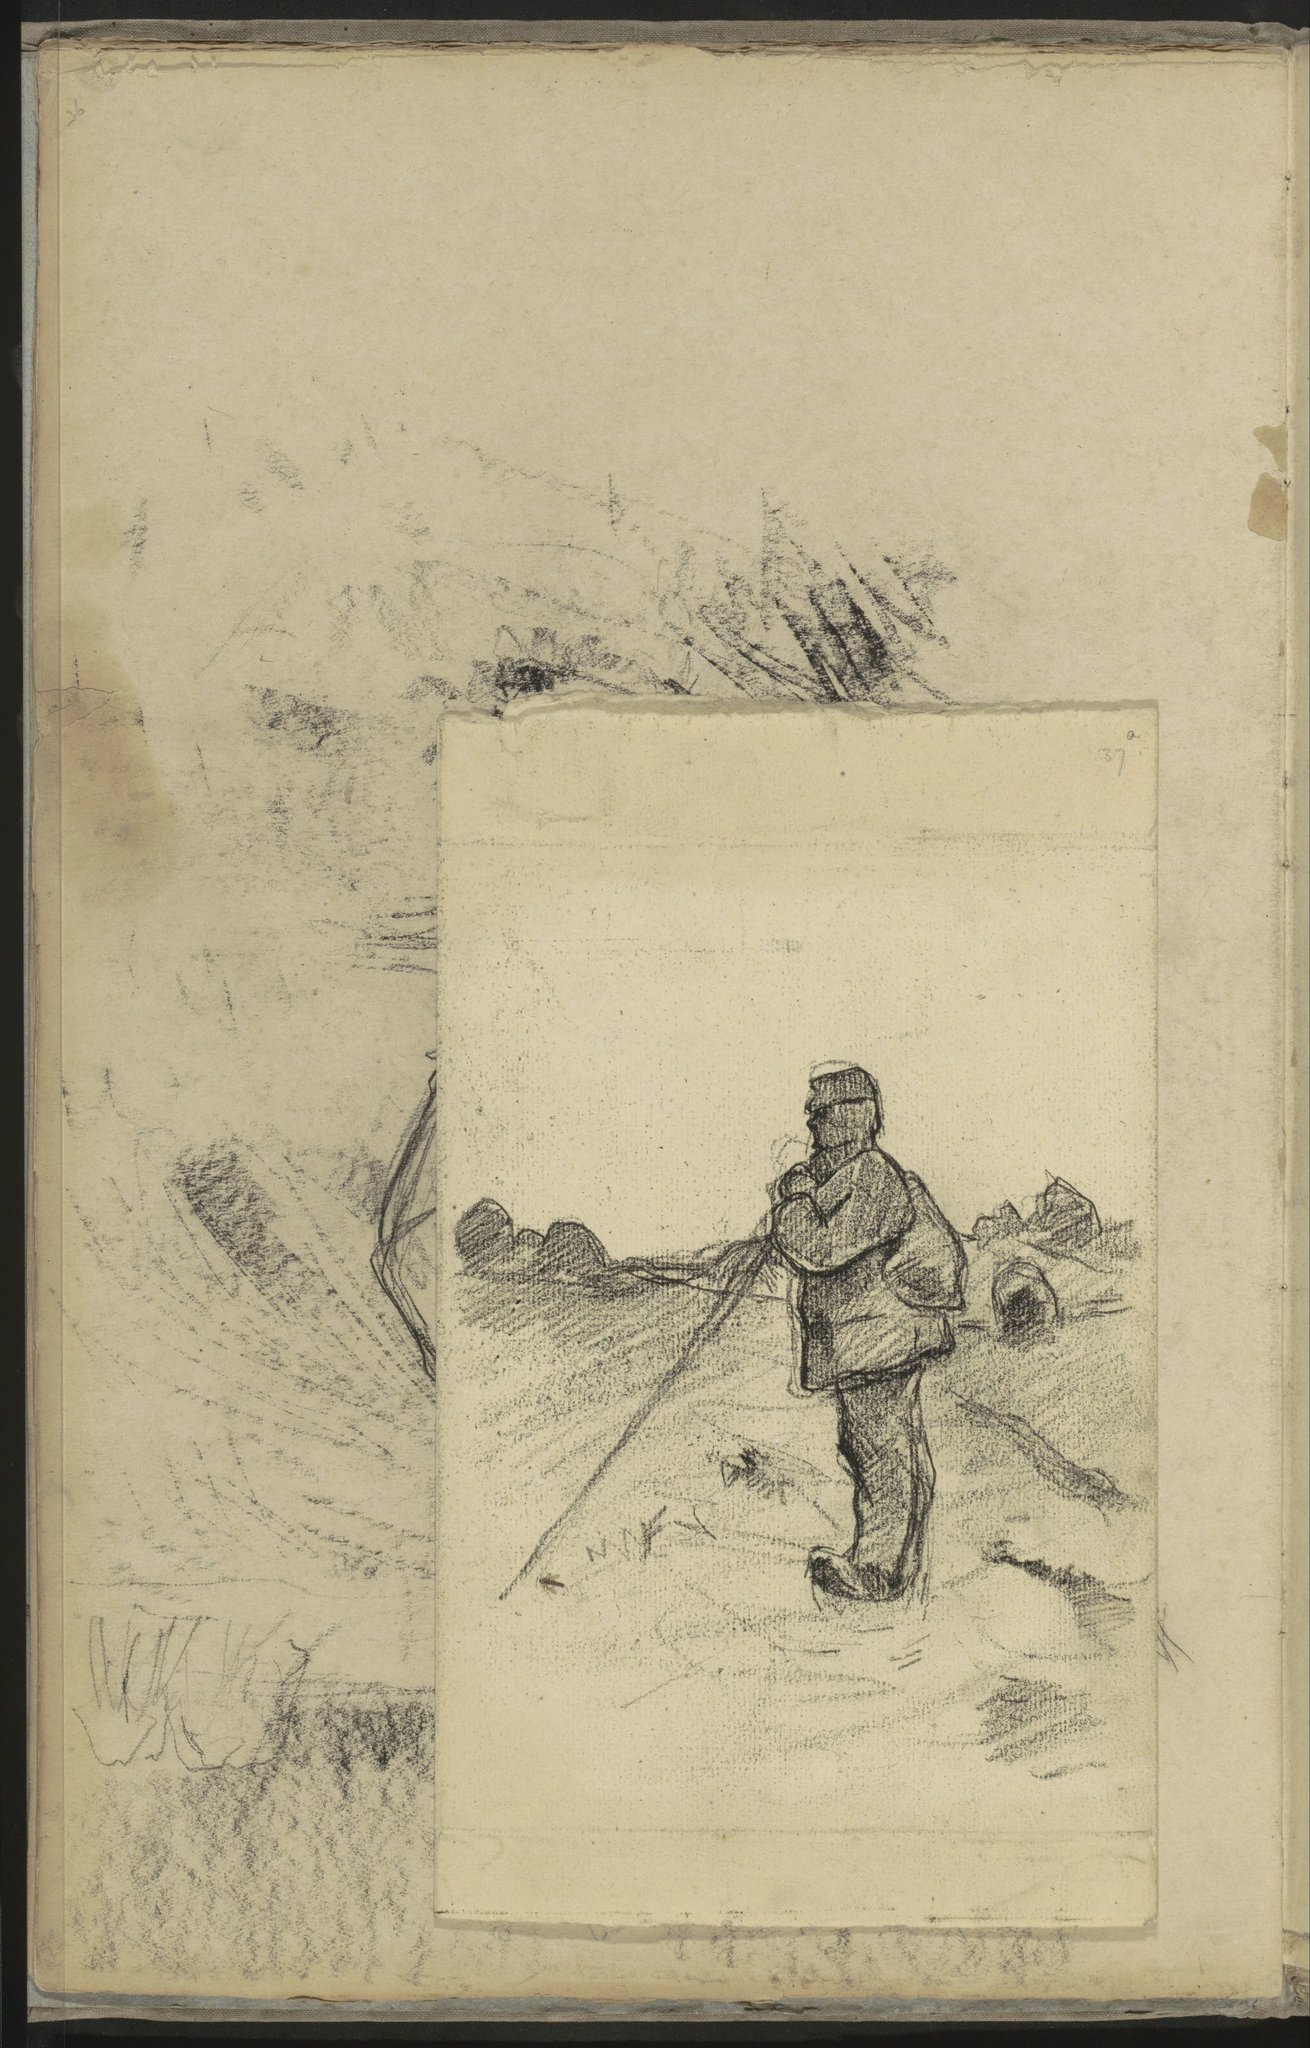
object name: sketchbook leaf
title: Schaapherder die op een staf leunt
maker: willem witsen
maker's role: draughtsman, painter, print maker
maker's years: 1860-1923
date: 1884-1887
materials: chalk, paper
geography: ewijkshoeve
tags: standing figure (+ leaning), cattle driving, cattle driver, sheep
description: Voorstudie voor de ets 'Staande schaapherder, leunend op zijn staf, kijkend naar rechts, ca. 1886-1906.